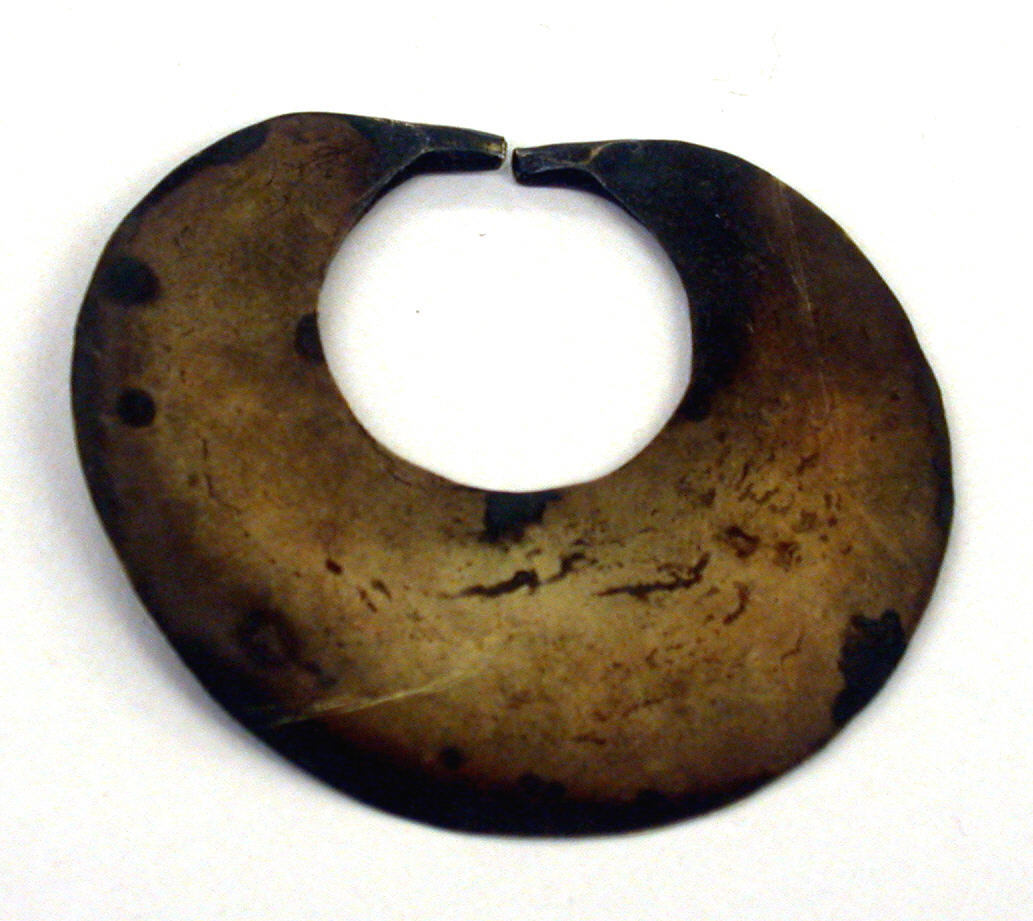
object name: nose ornament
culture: moche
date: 501-700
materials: gold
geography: peru